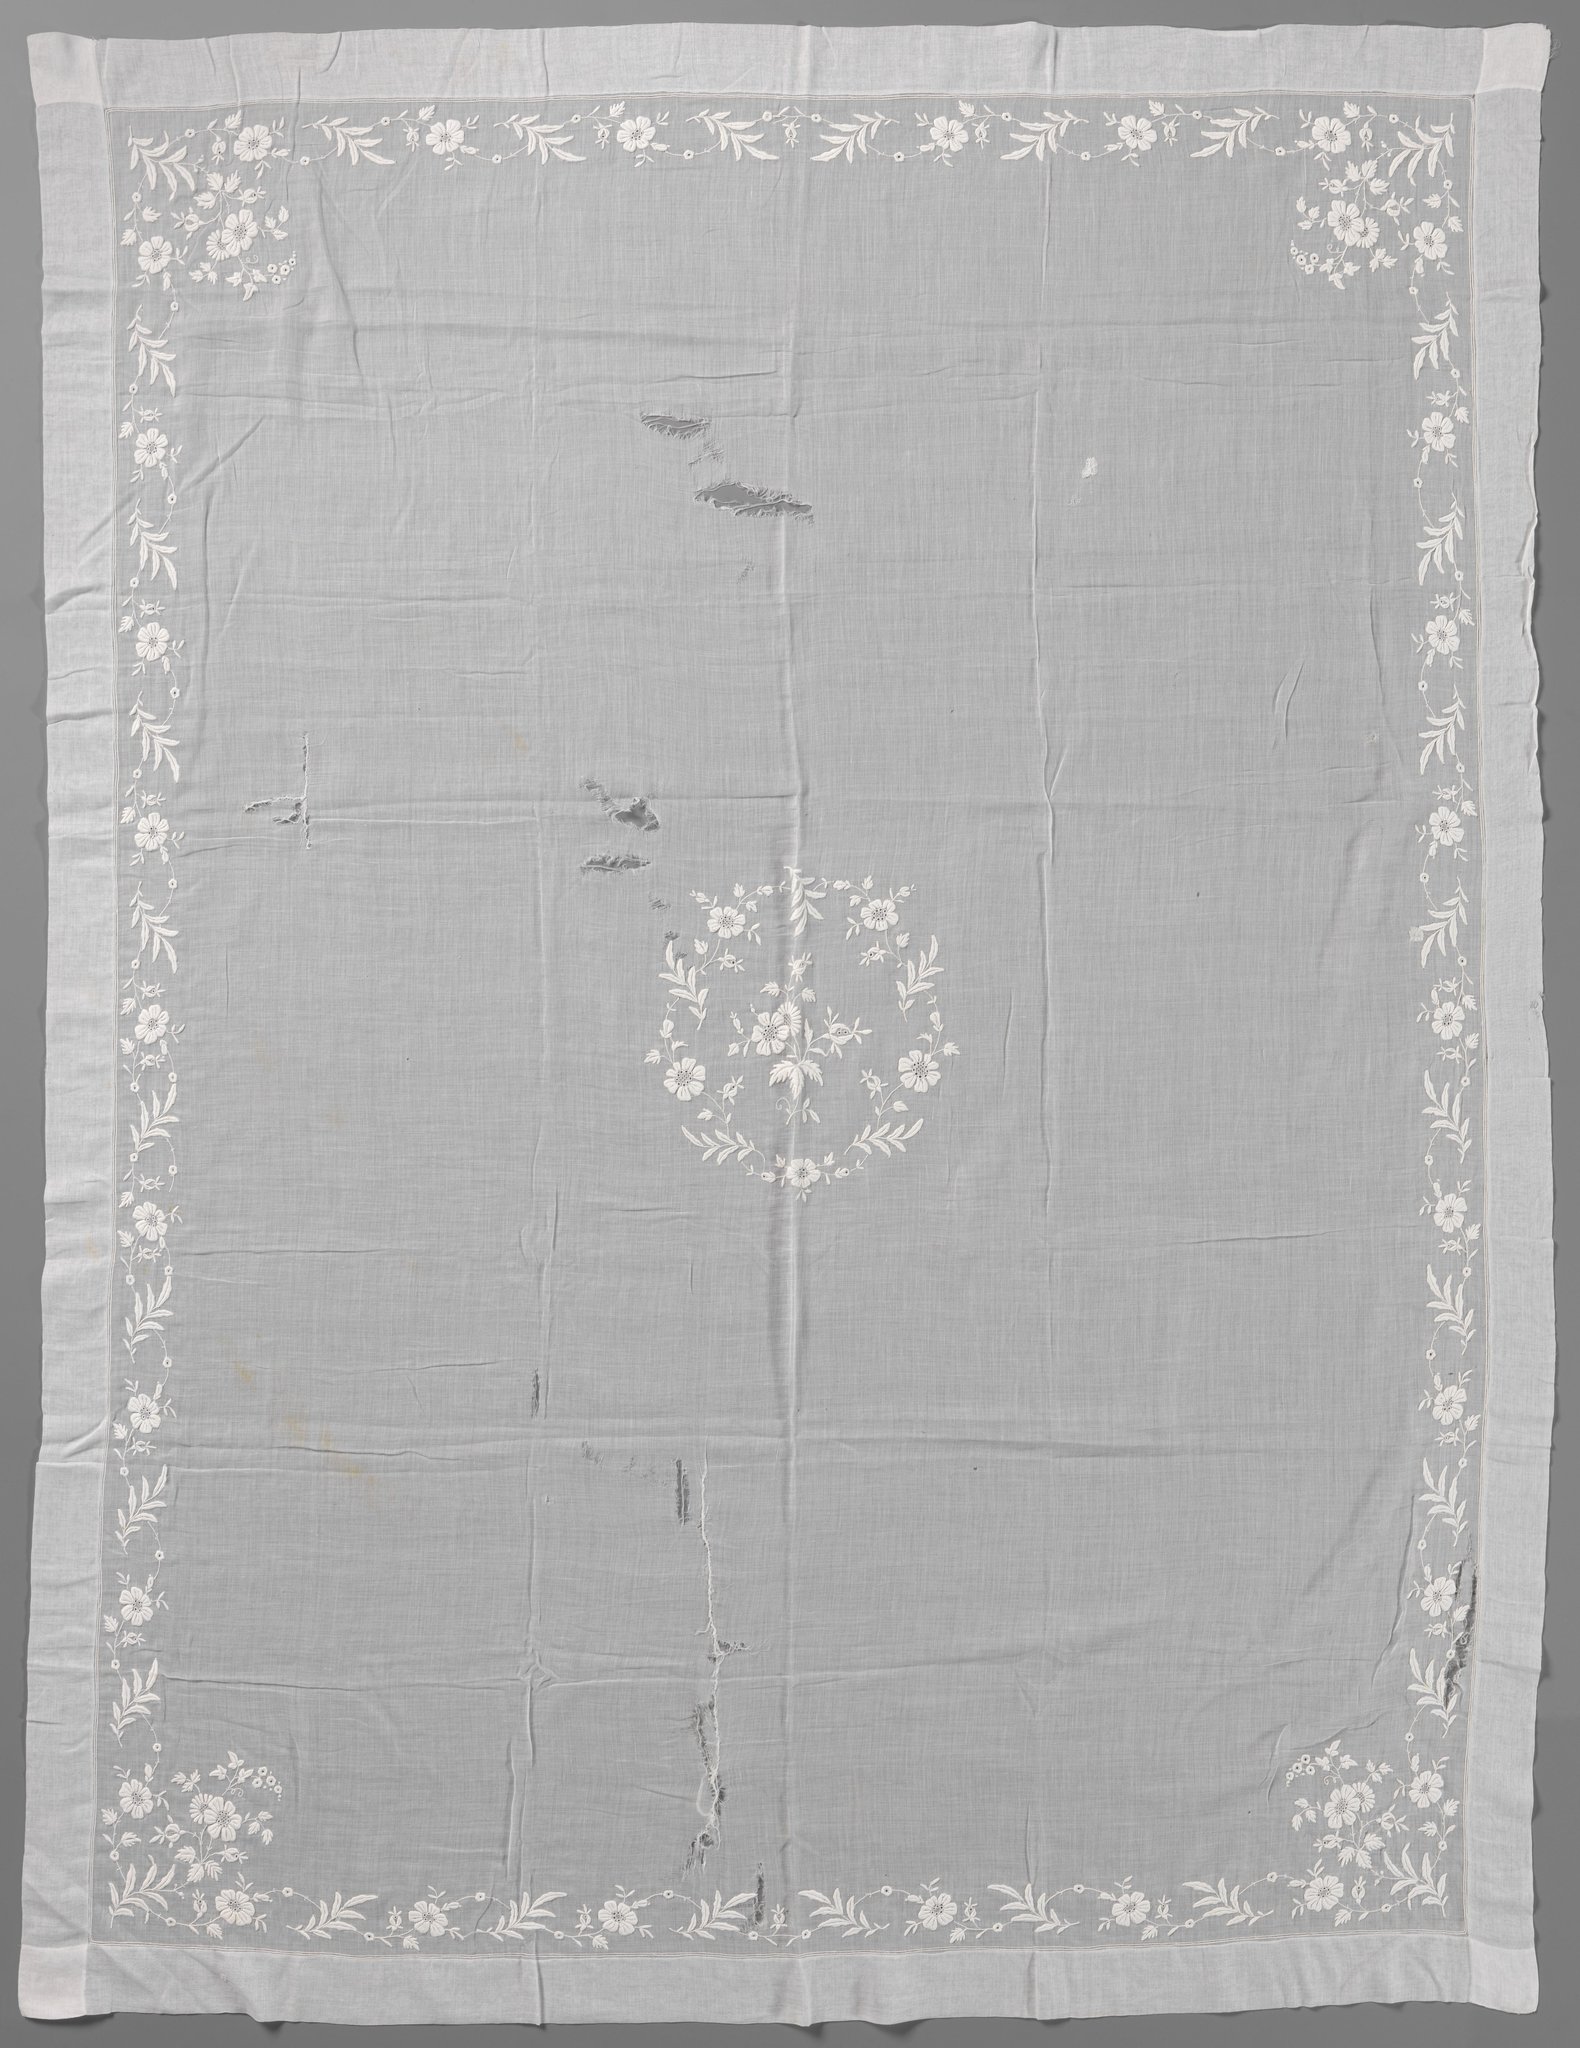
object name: kleed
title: Kleed van batist geborduurd met witte roosjes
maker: Anonymous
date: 1870-1880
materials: textile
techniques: embroidered, satin stitch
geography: netherlands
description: Kleed van batist geborduurd met witte roosjes. Mogelijk een doopkleed. Langs een gladde zoom loopt een golvende, zeer ijle tak met dikke wilde roosjes, oversneden door losse blaadjes. In de hoeken telkens een vollere rozentak. In het midden een dergelijke tak in een krans.